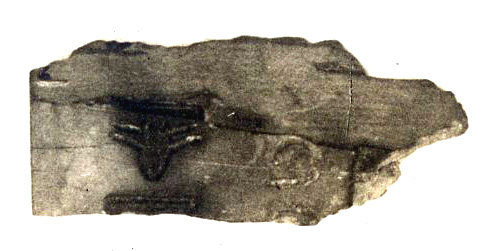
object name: ivory tab, den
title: Fragment of an ivory tag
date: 3013-2999 BCE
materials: ivory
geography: egypt